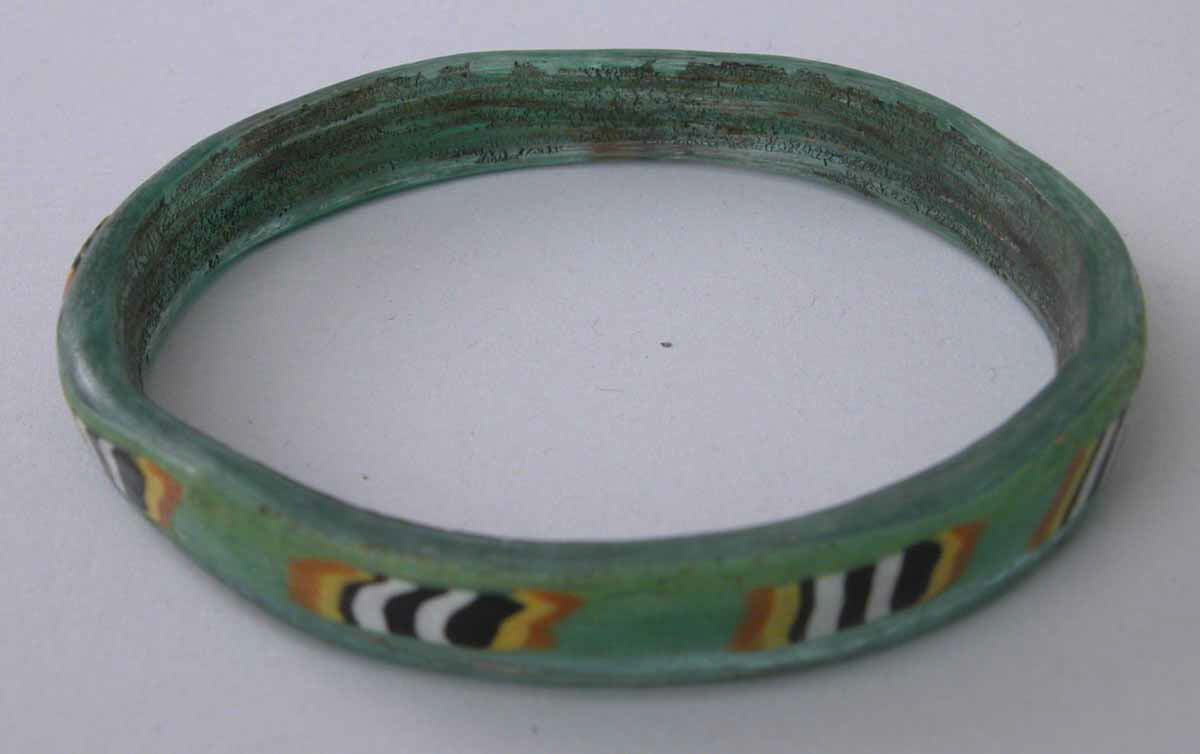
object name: bracelet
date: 1301-1500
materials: glass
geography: egypt or syria